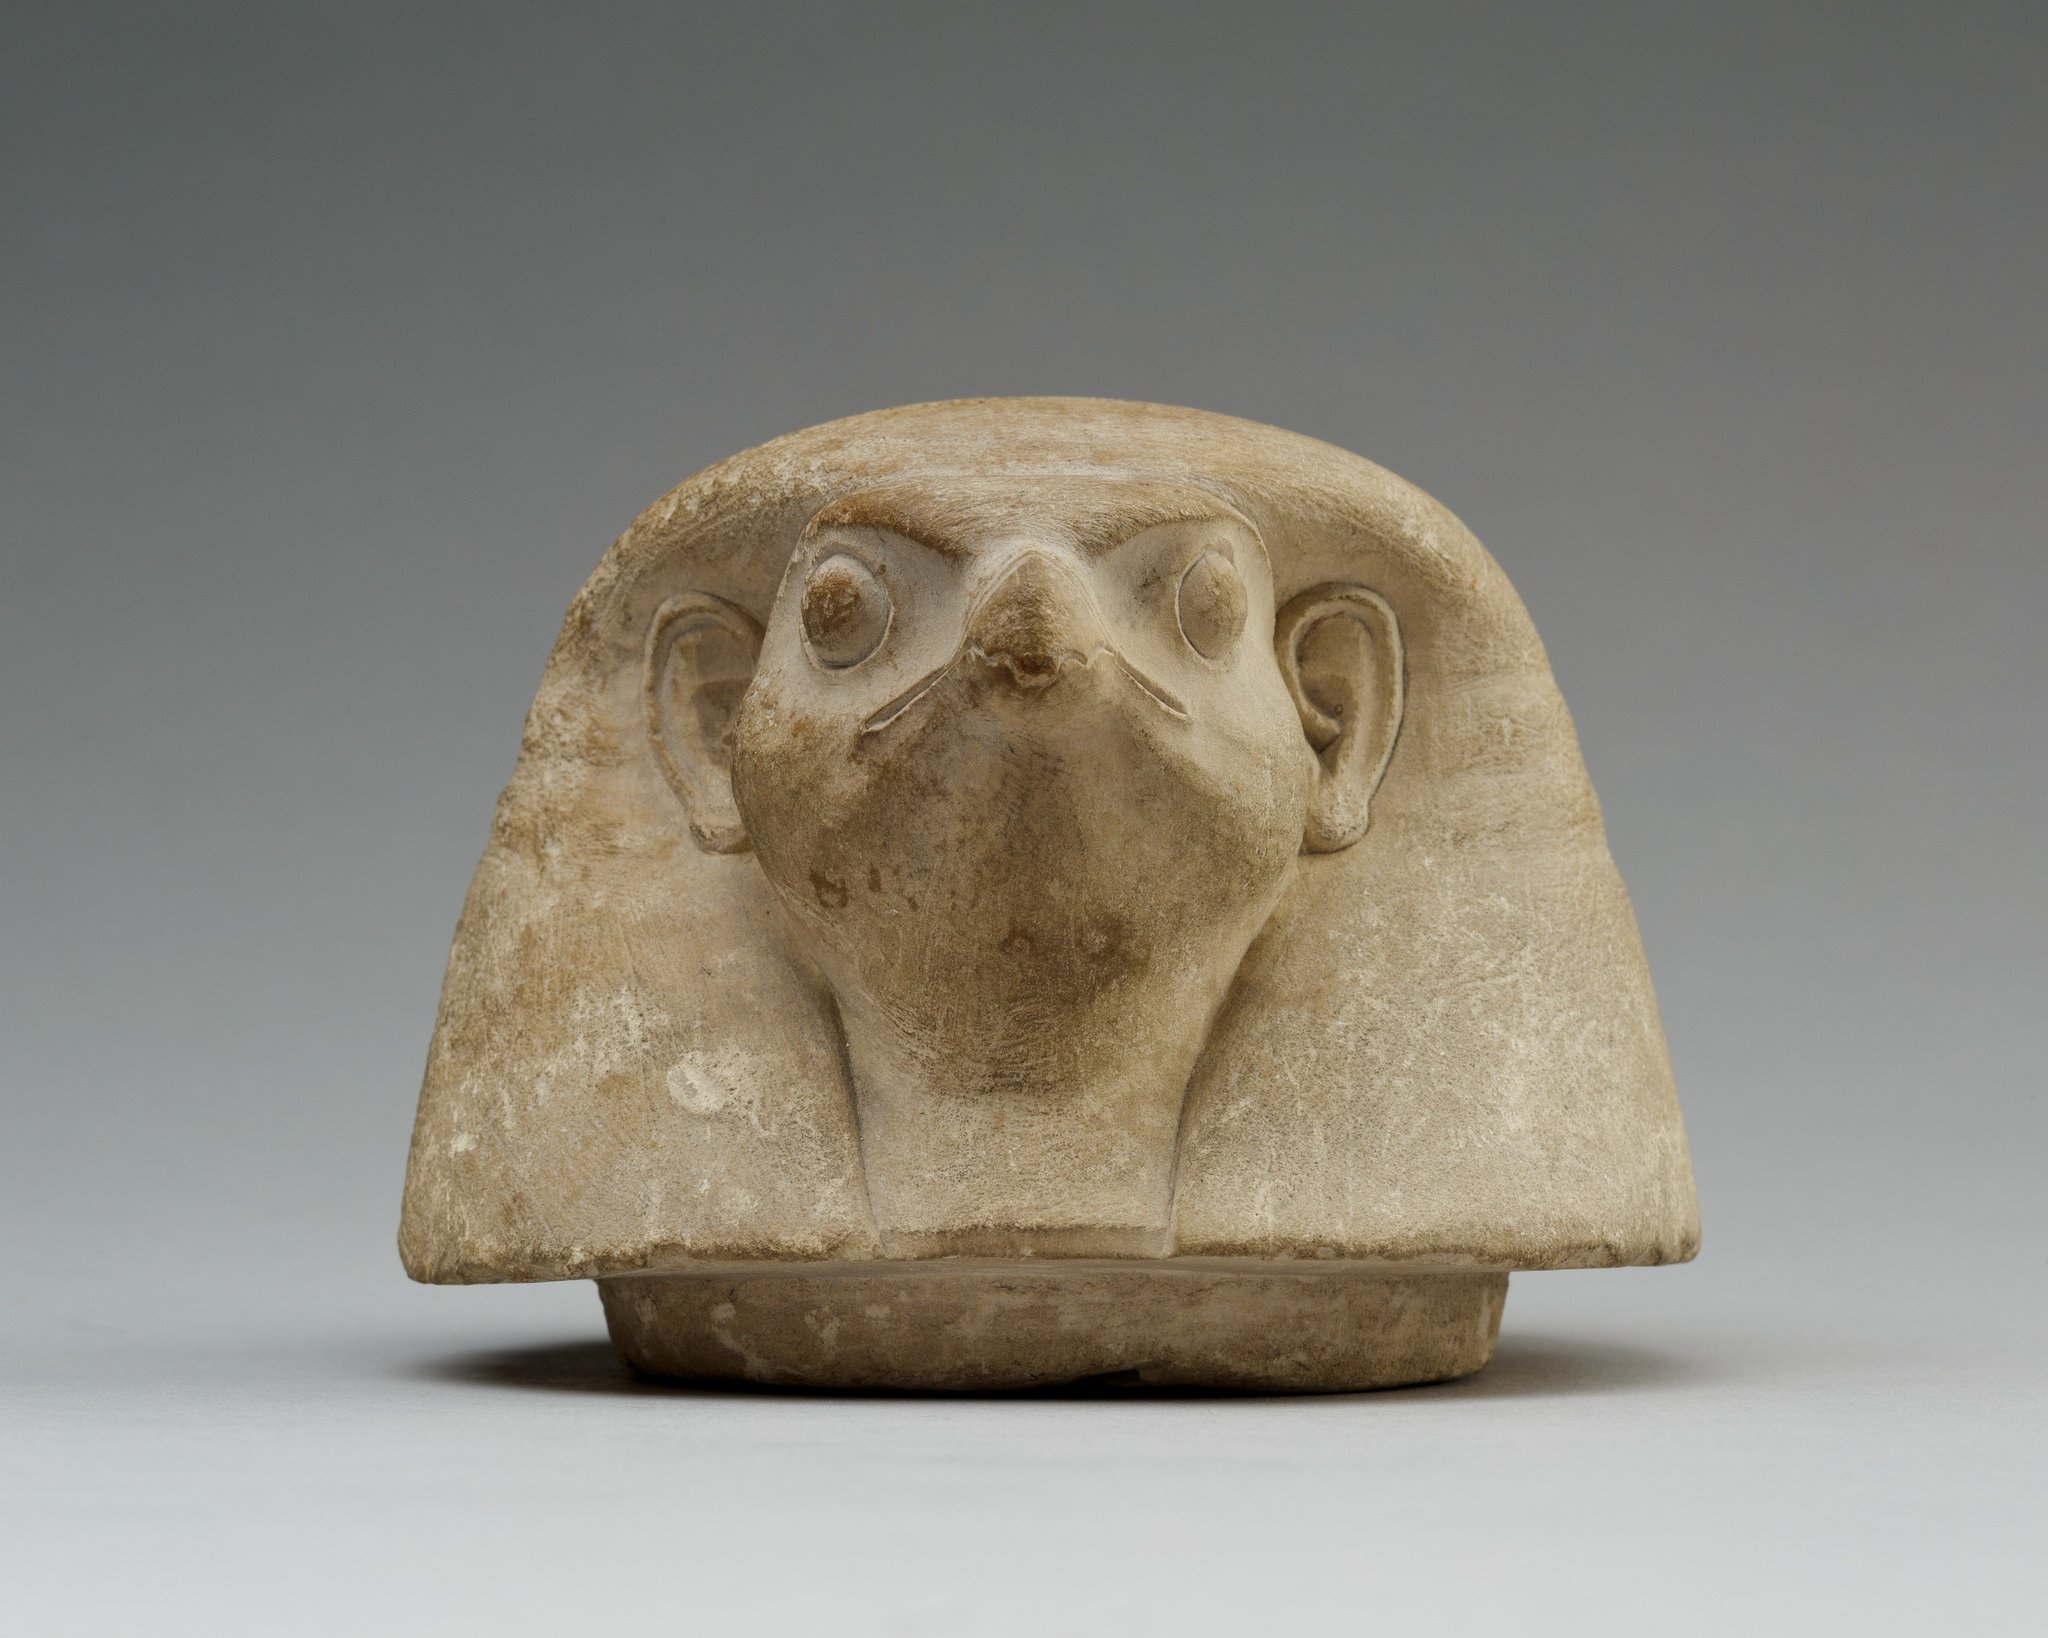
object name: canopic jar lid, falcon head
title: Canopic jar lid with falcon head (Qebehsenuef)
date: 664-525 BCE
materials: limestone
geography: egypt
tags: falcons